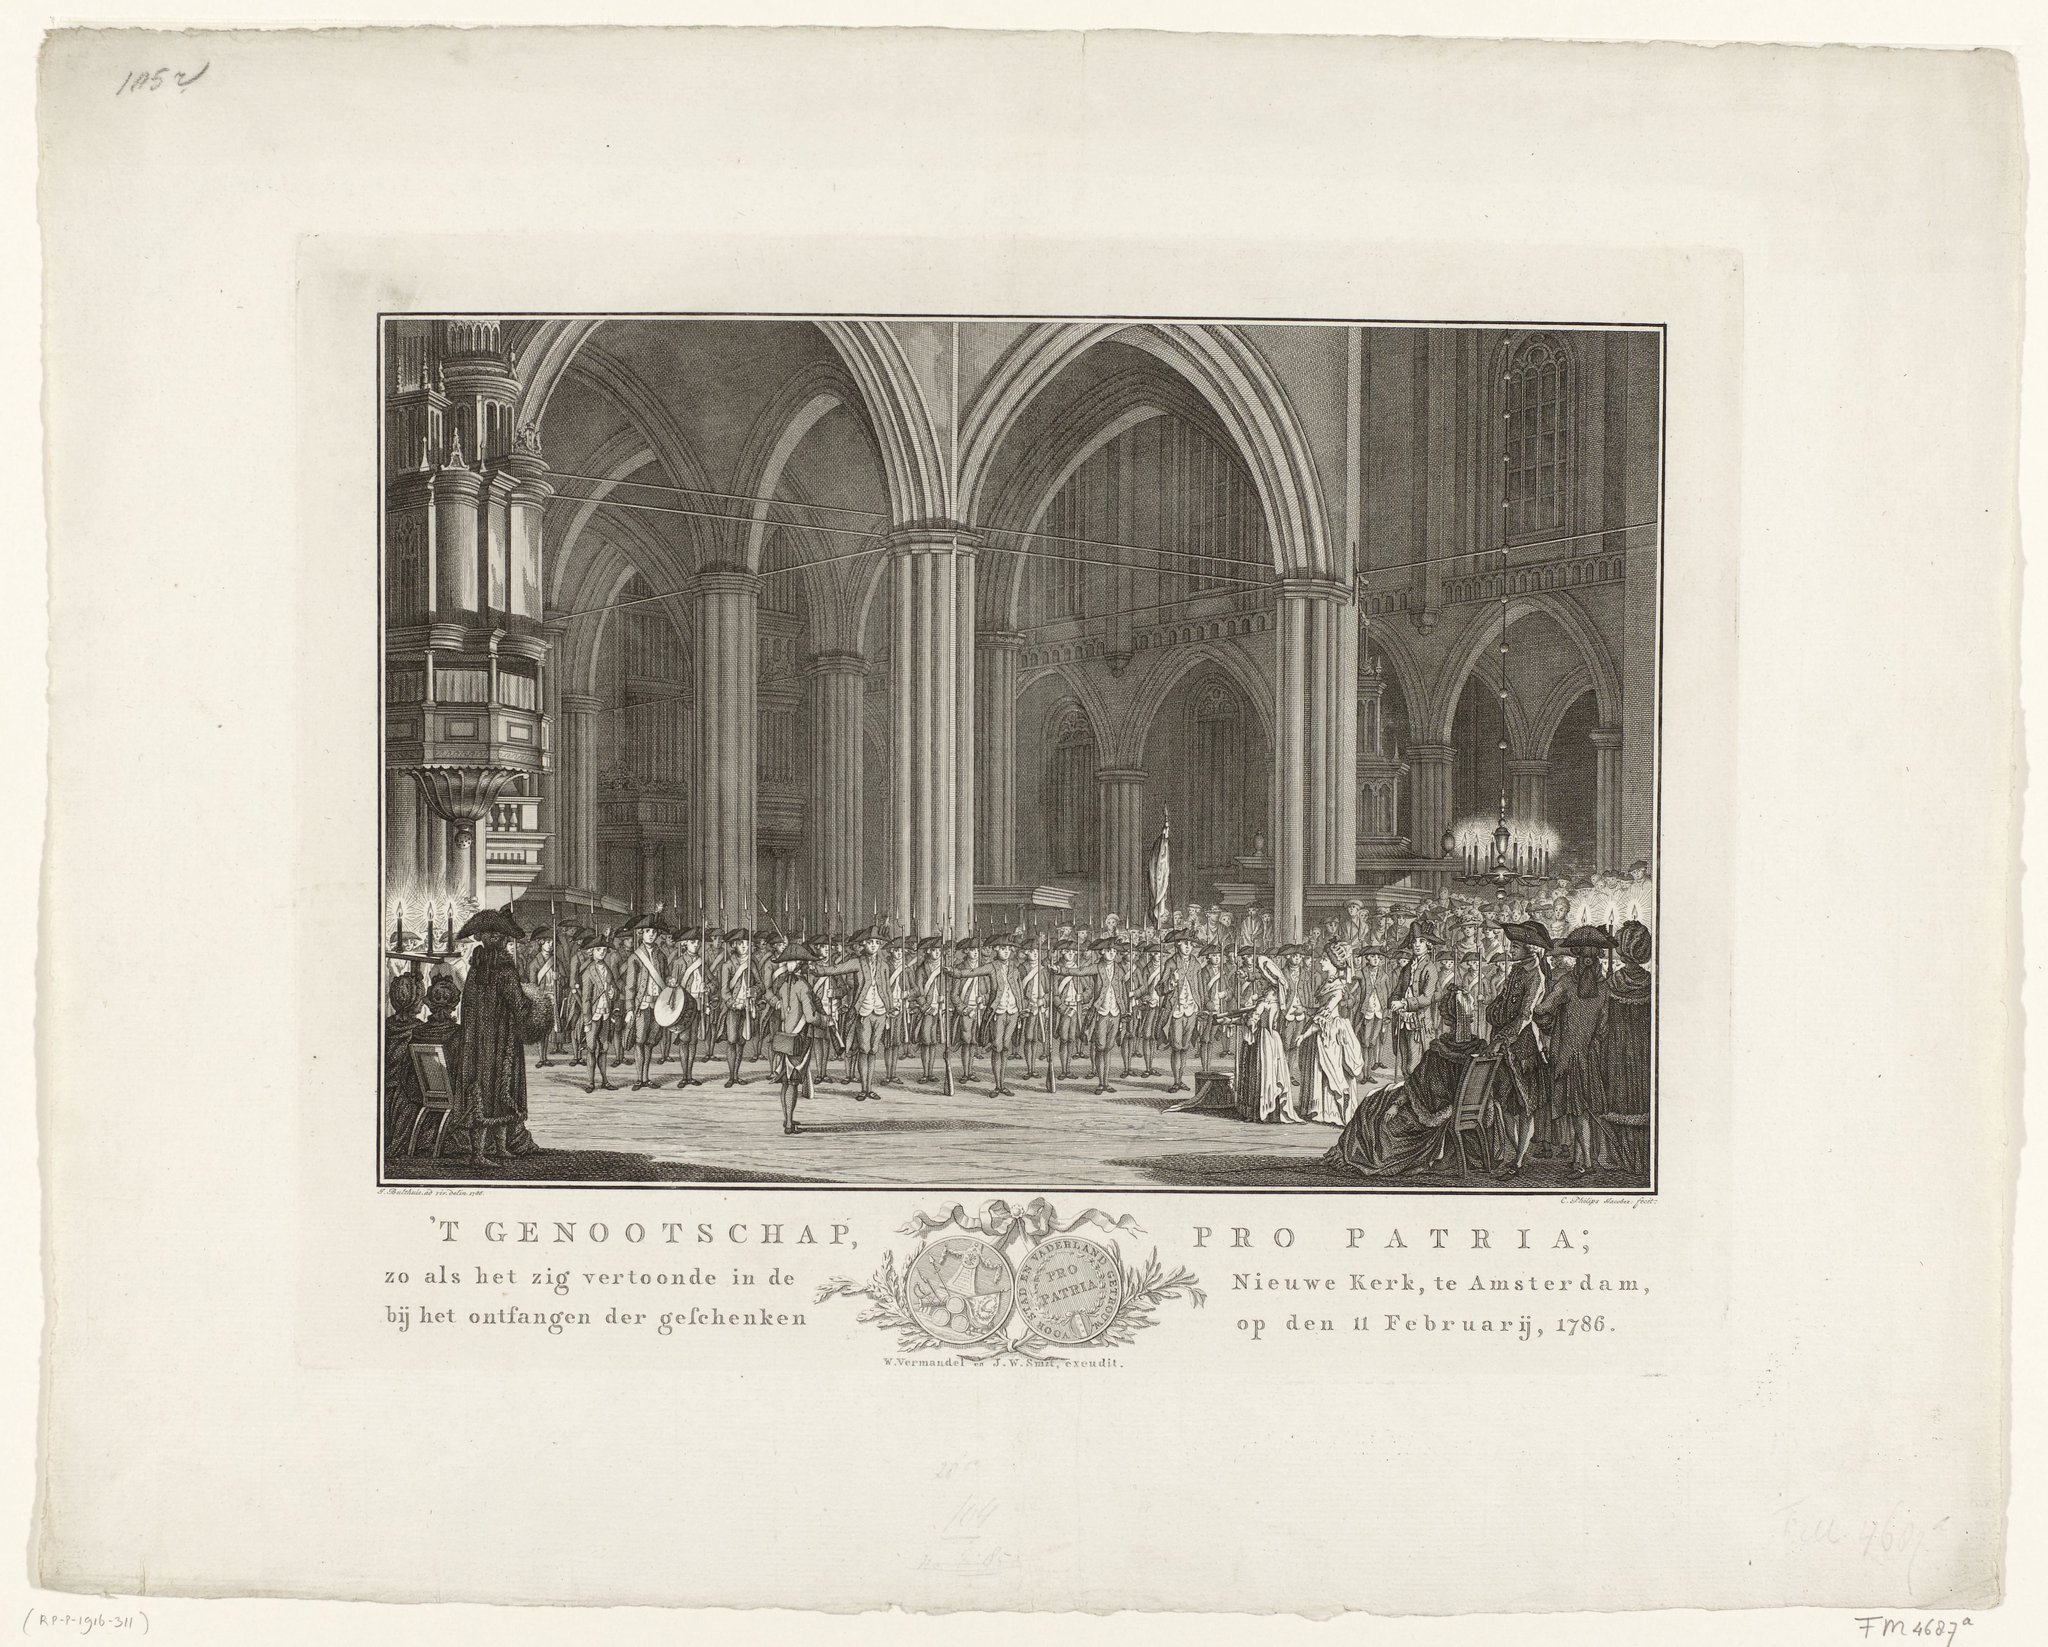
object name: print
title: 'T Genootschap, Pro Patria; zo als het zig vertoonde in de Nieuwe Kerk, te Amsterdam, bij het ontfangen der geschenken op den 11 Februarij, 1786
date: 1786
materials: paper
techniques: engraving, etching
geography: northern netherlands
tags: warfare; military affairs (+ citizen soldiery, civil guard, citizen militia)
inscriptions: collector's mark: Lugt 2228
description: Bijeenkomst van het Genootschap ter Oefening van de Wapenhandel Pro Patria in de Nieuwe Kerk te Amsterdam op 11 februari 1786, waar geschenken, overhandigd door een vrouw, in ontvangst worden genomen. In de marge voor- en keerzijde van een medaille van het genootschap.